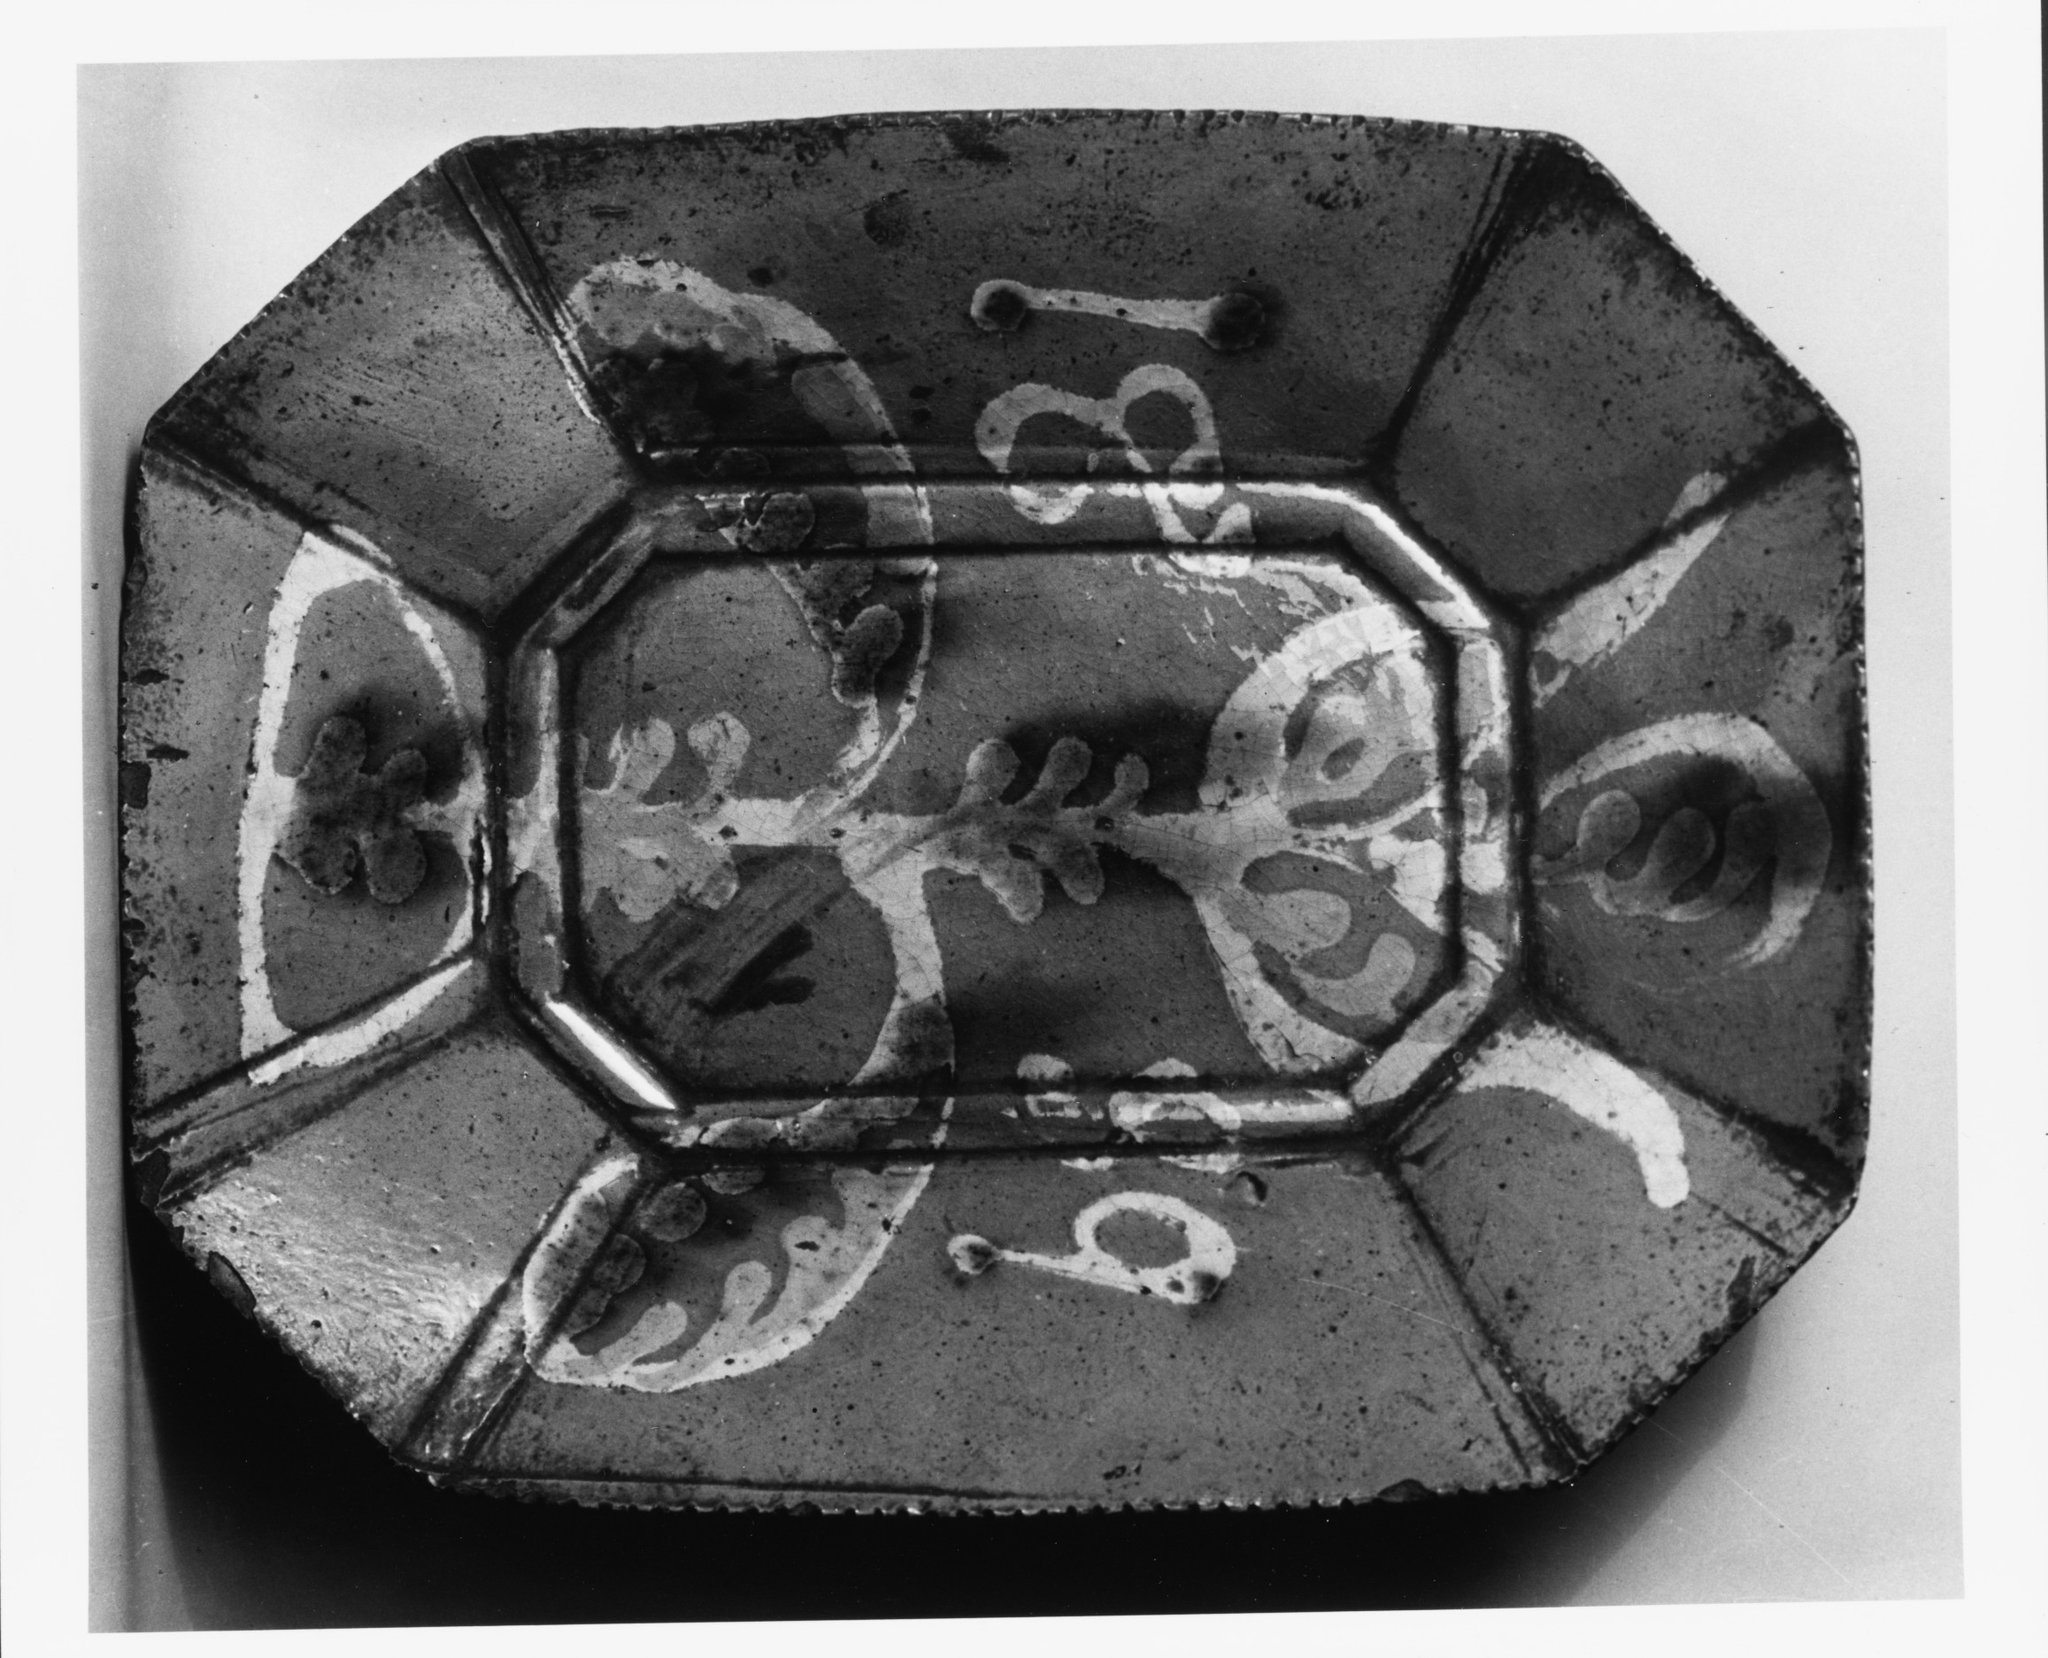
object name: dish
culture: american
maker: simon singer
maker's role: artist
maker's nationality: american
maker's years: 1822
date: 1889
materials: earthenware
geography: united states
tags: flowers